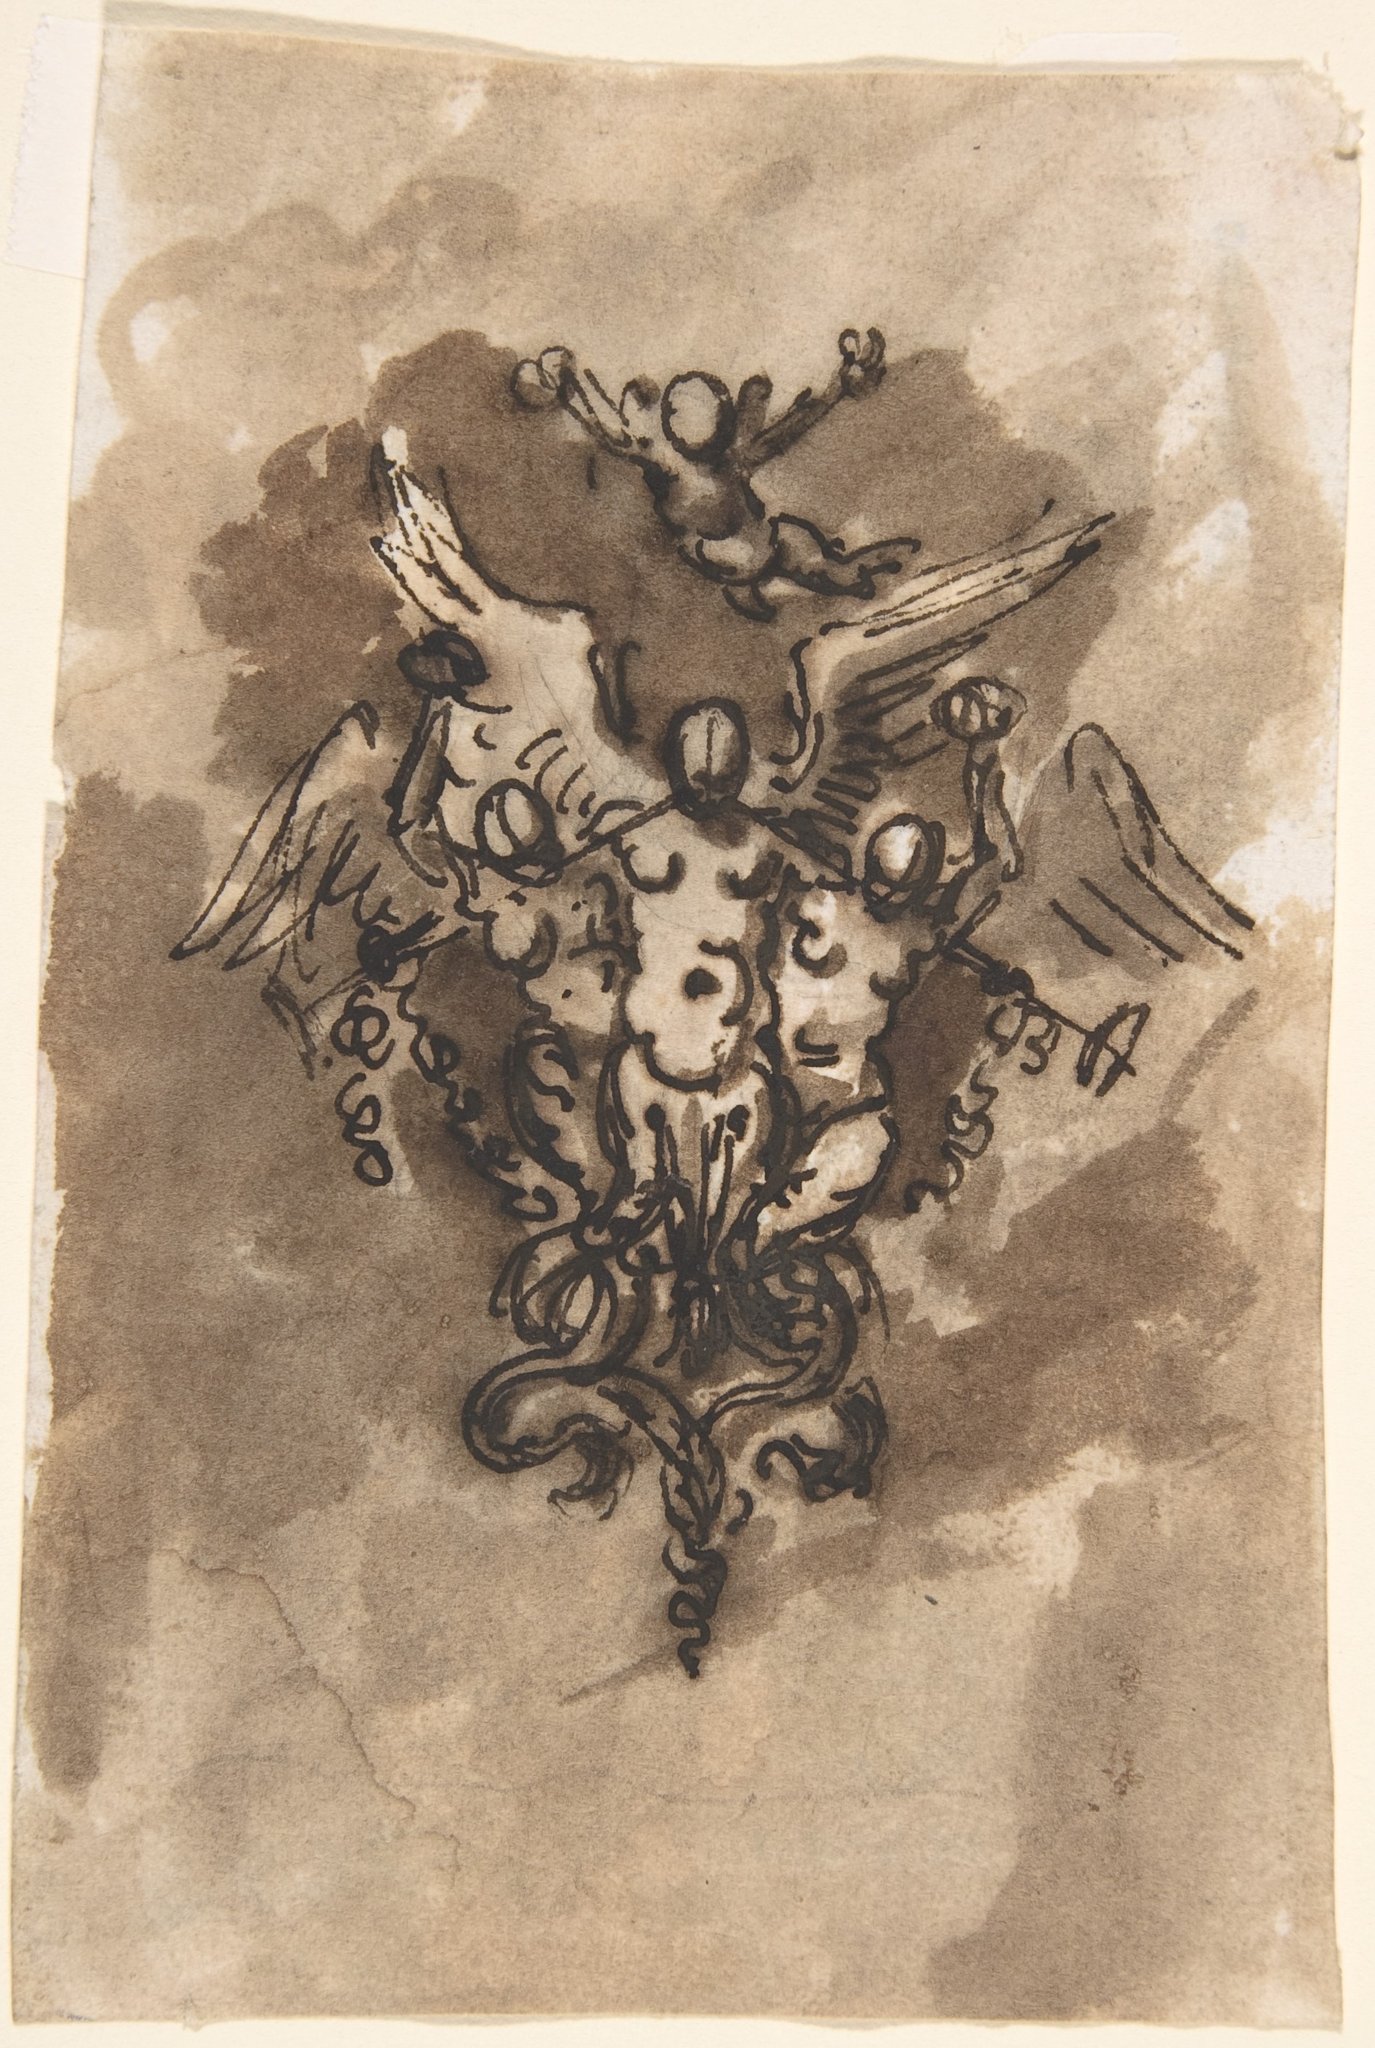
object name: drawing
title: Drawing for a Vignette of Fame (recto); Cropped Drawing of Horse's Leg (verso)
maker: anonymous, italian, 18th century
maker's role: artist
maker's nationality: italian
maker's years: 1700-1800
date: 1701-1800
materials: graphite, ink, lead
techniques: brush, pen, wash